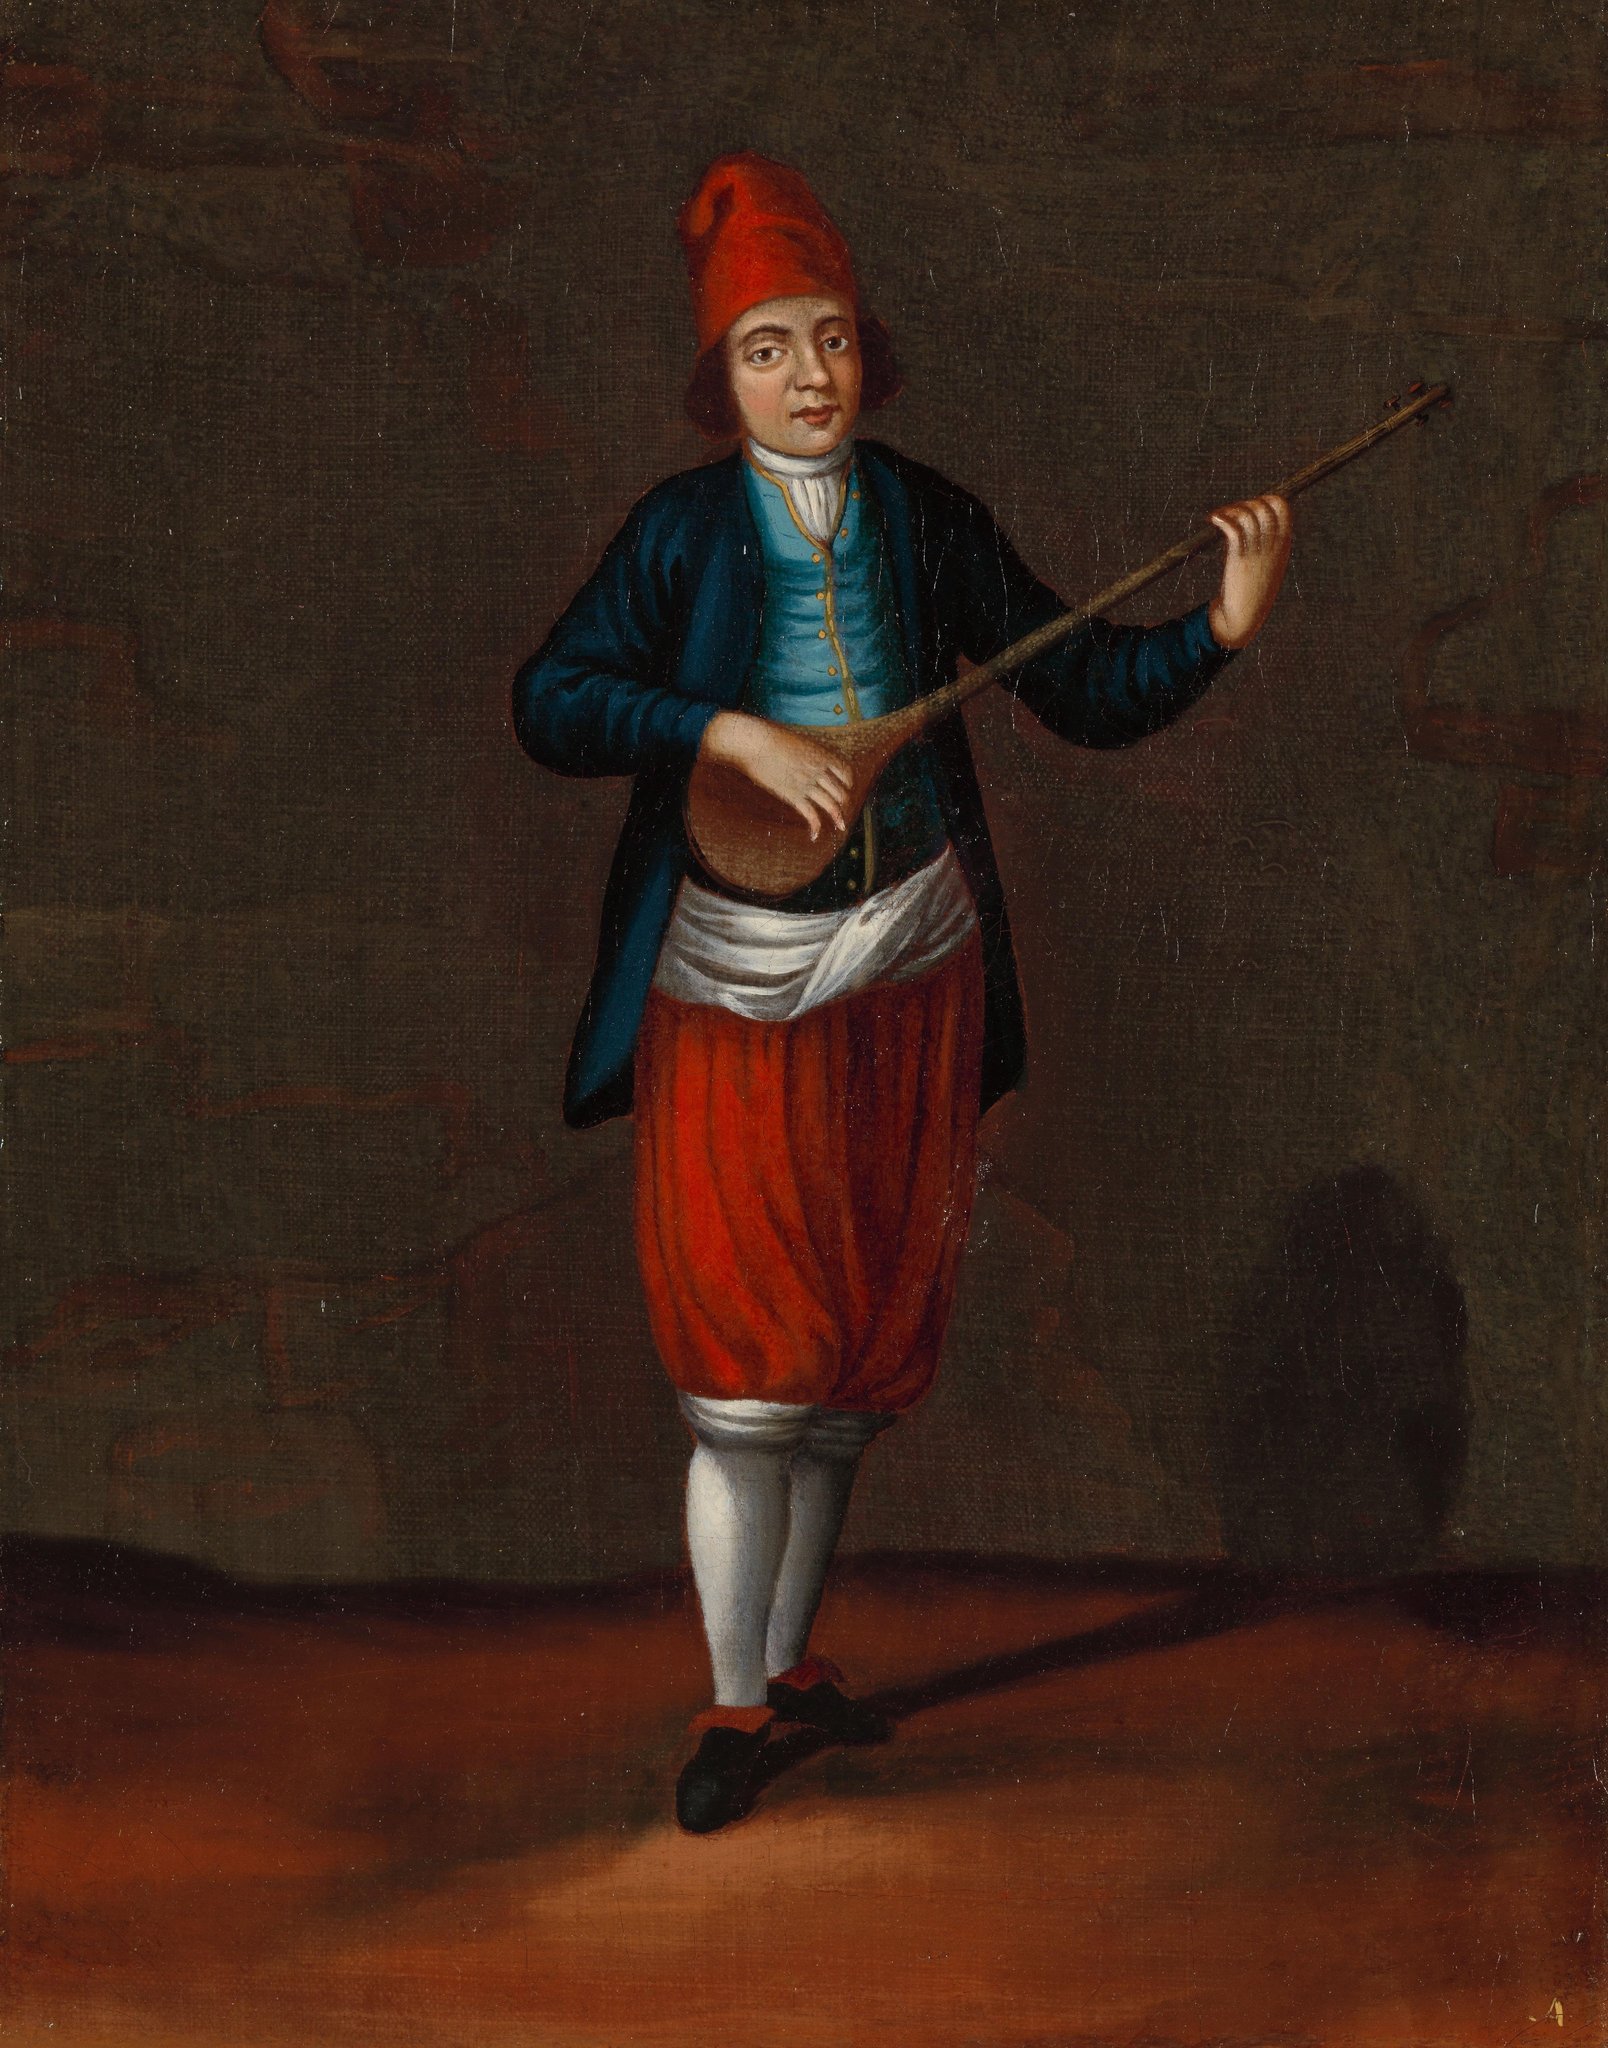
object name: painting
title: Man from the Island of Sérifos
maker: jean baptiste vanmour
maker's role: painter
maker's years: 1671-1737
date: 1700-1737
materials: canvas, oil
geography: istanbul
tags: standing figure, folk costume, regional costume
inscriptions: number: ‘24’, inscription: ‘Serifiote / Eilanden van Serifo’